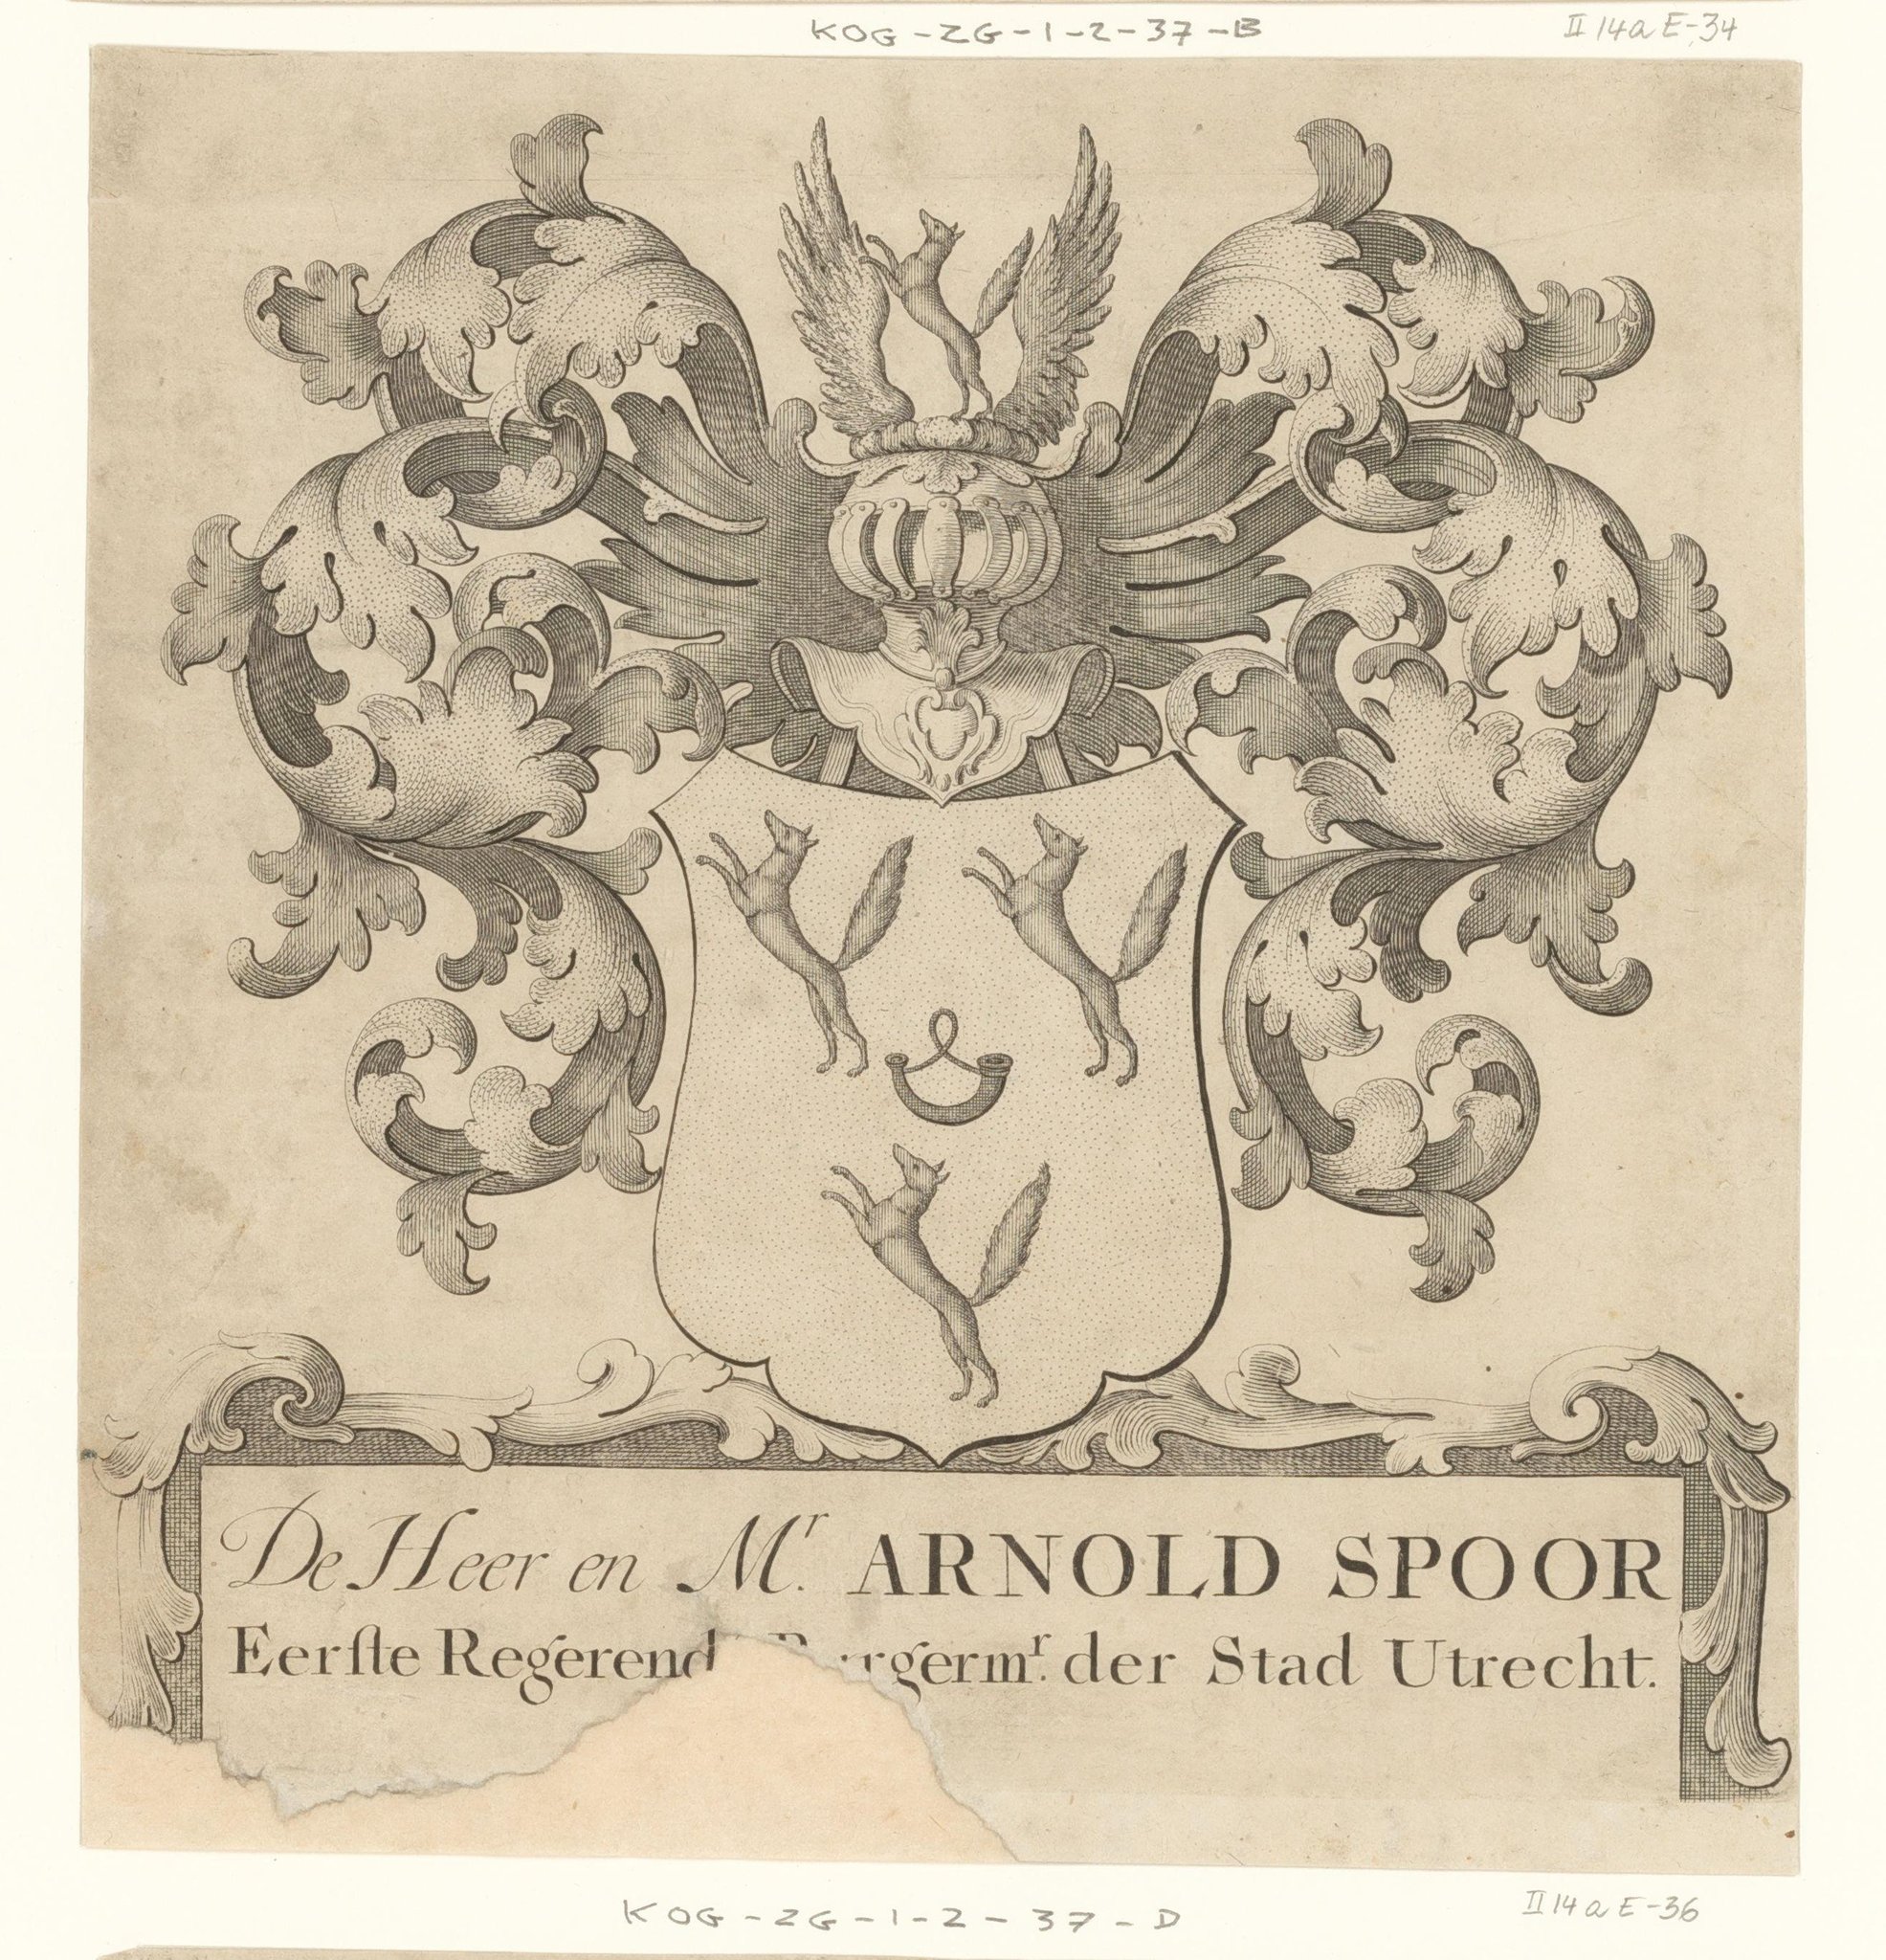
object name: print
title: Familiewapen van Mr. Arnold Spoor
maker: Anonymous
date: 1689-1690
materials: paper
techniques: engraving, etching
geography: netherlands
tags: mayor, burgomaster, armorial bearing, heraldry, utrecht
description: Familiewapen van Mr. Arnold Spoor, burgemeester van Utrecht (1688-1690). Onderdeel van een groep van twaalf wapens van magistraten van Utrecht. Mogelijk behorend bij een grote kaart van bijvoorbeeld een hoogheemraadschap. Onderwerpsrubrieken binnen de Atlas Zeden en Gewoonten: Regeering, Wapens (Heraldiek), Geslachtswapens.